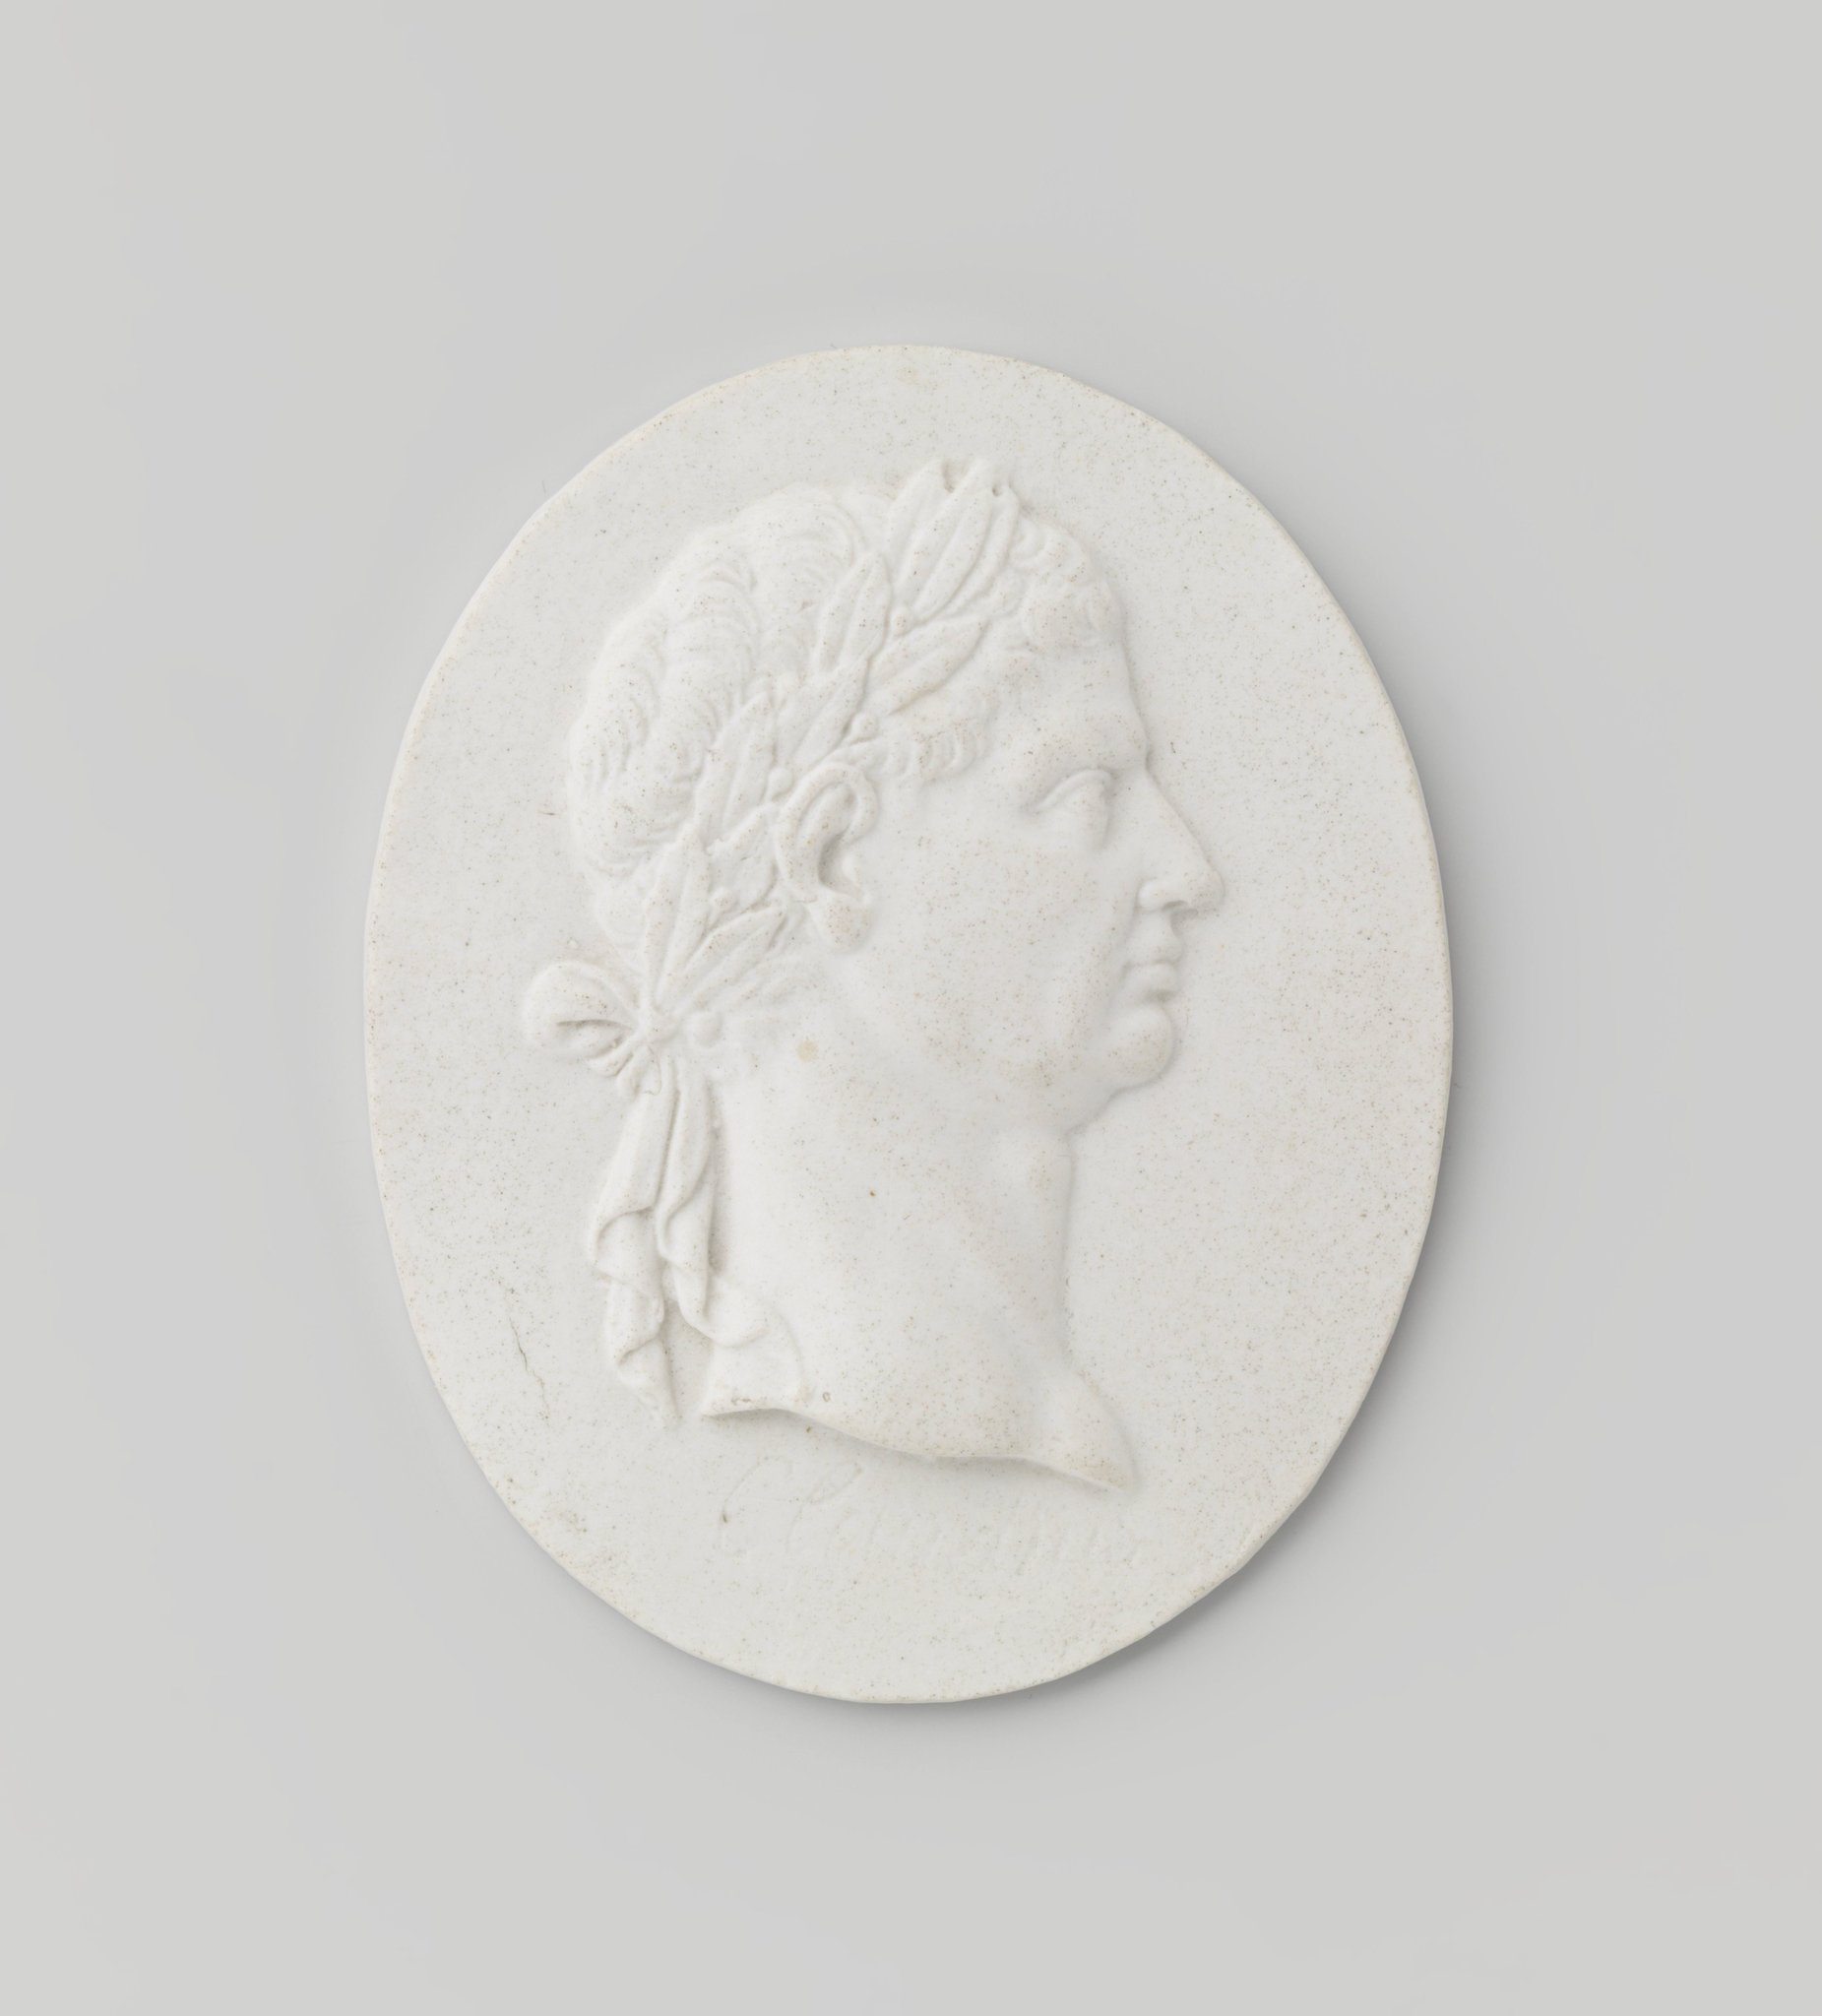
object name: portretmedaillon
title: Keizer Claudius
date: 1782-1784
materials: porcelain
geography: loosdrecht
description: Five portrait medallions of the Roman Emperors Augustus, Claudius, Vespasian, Titus and Domitian. Biscuit porcelain. Loosdrecht, c. 1778 - 1782. Factory of Joannes de Mol.